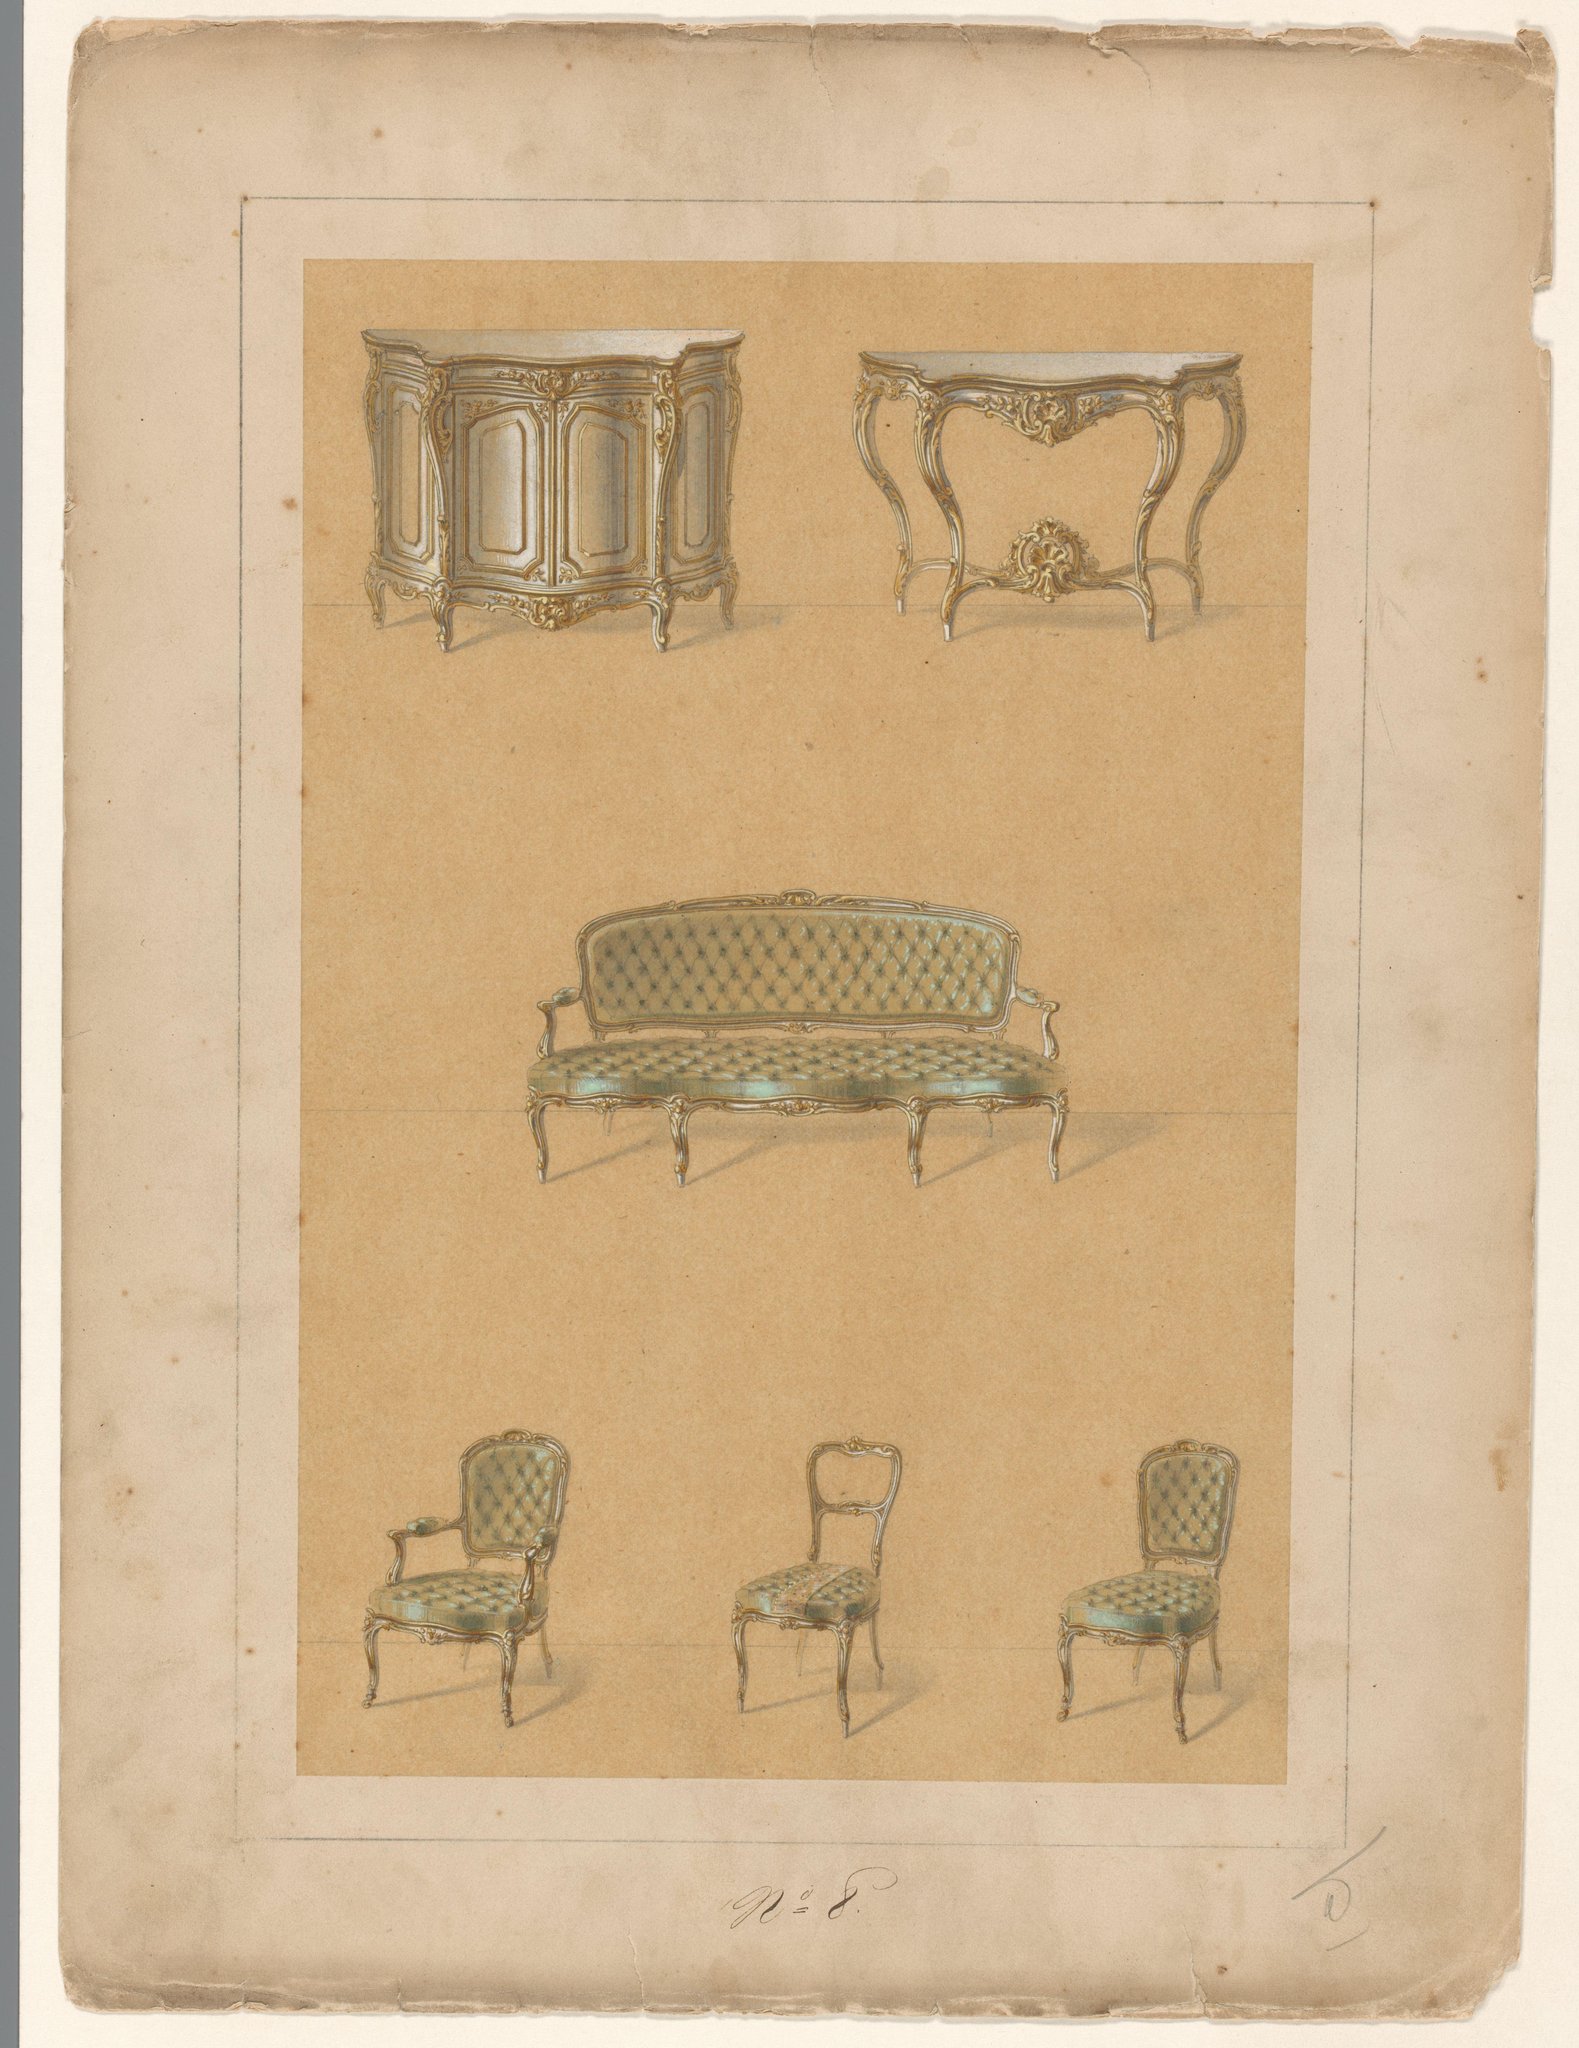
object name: print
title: Kast, consoletafel, bank, fauteuil en stoelen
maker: Anonymous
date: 1800-1900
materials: paper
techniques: hand coloring, lithograph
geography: france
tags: seating furniture, table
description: Een lage kast, een consoletafel, een bank, een fauteuil en twee stoelen. Midden onder genummerd No 8.